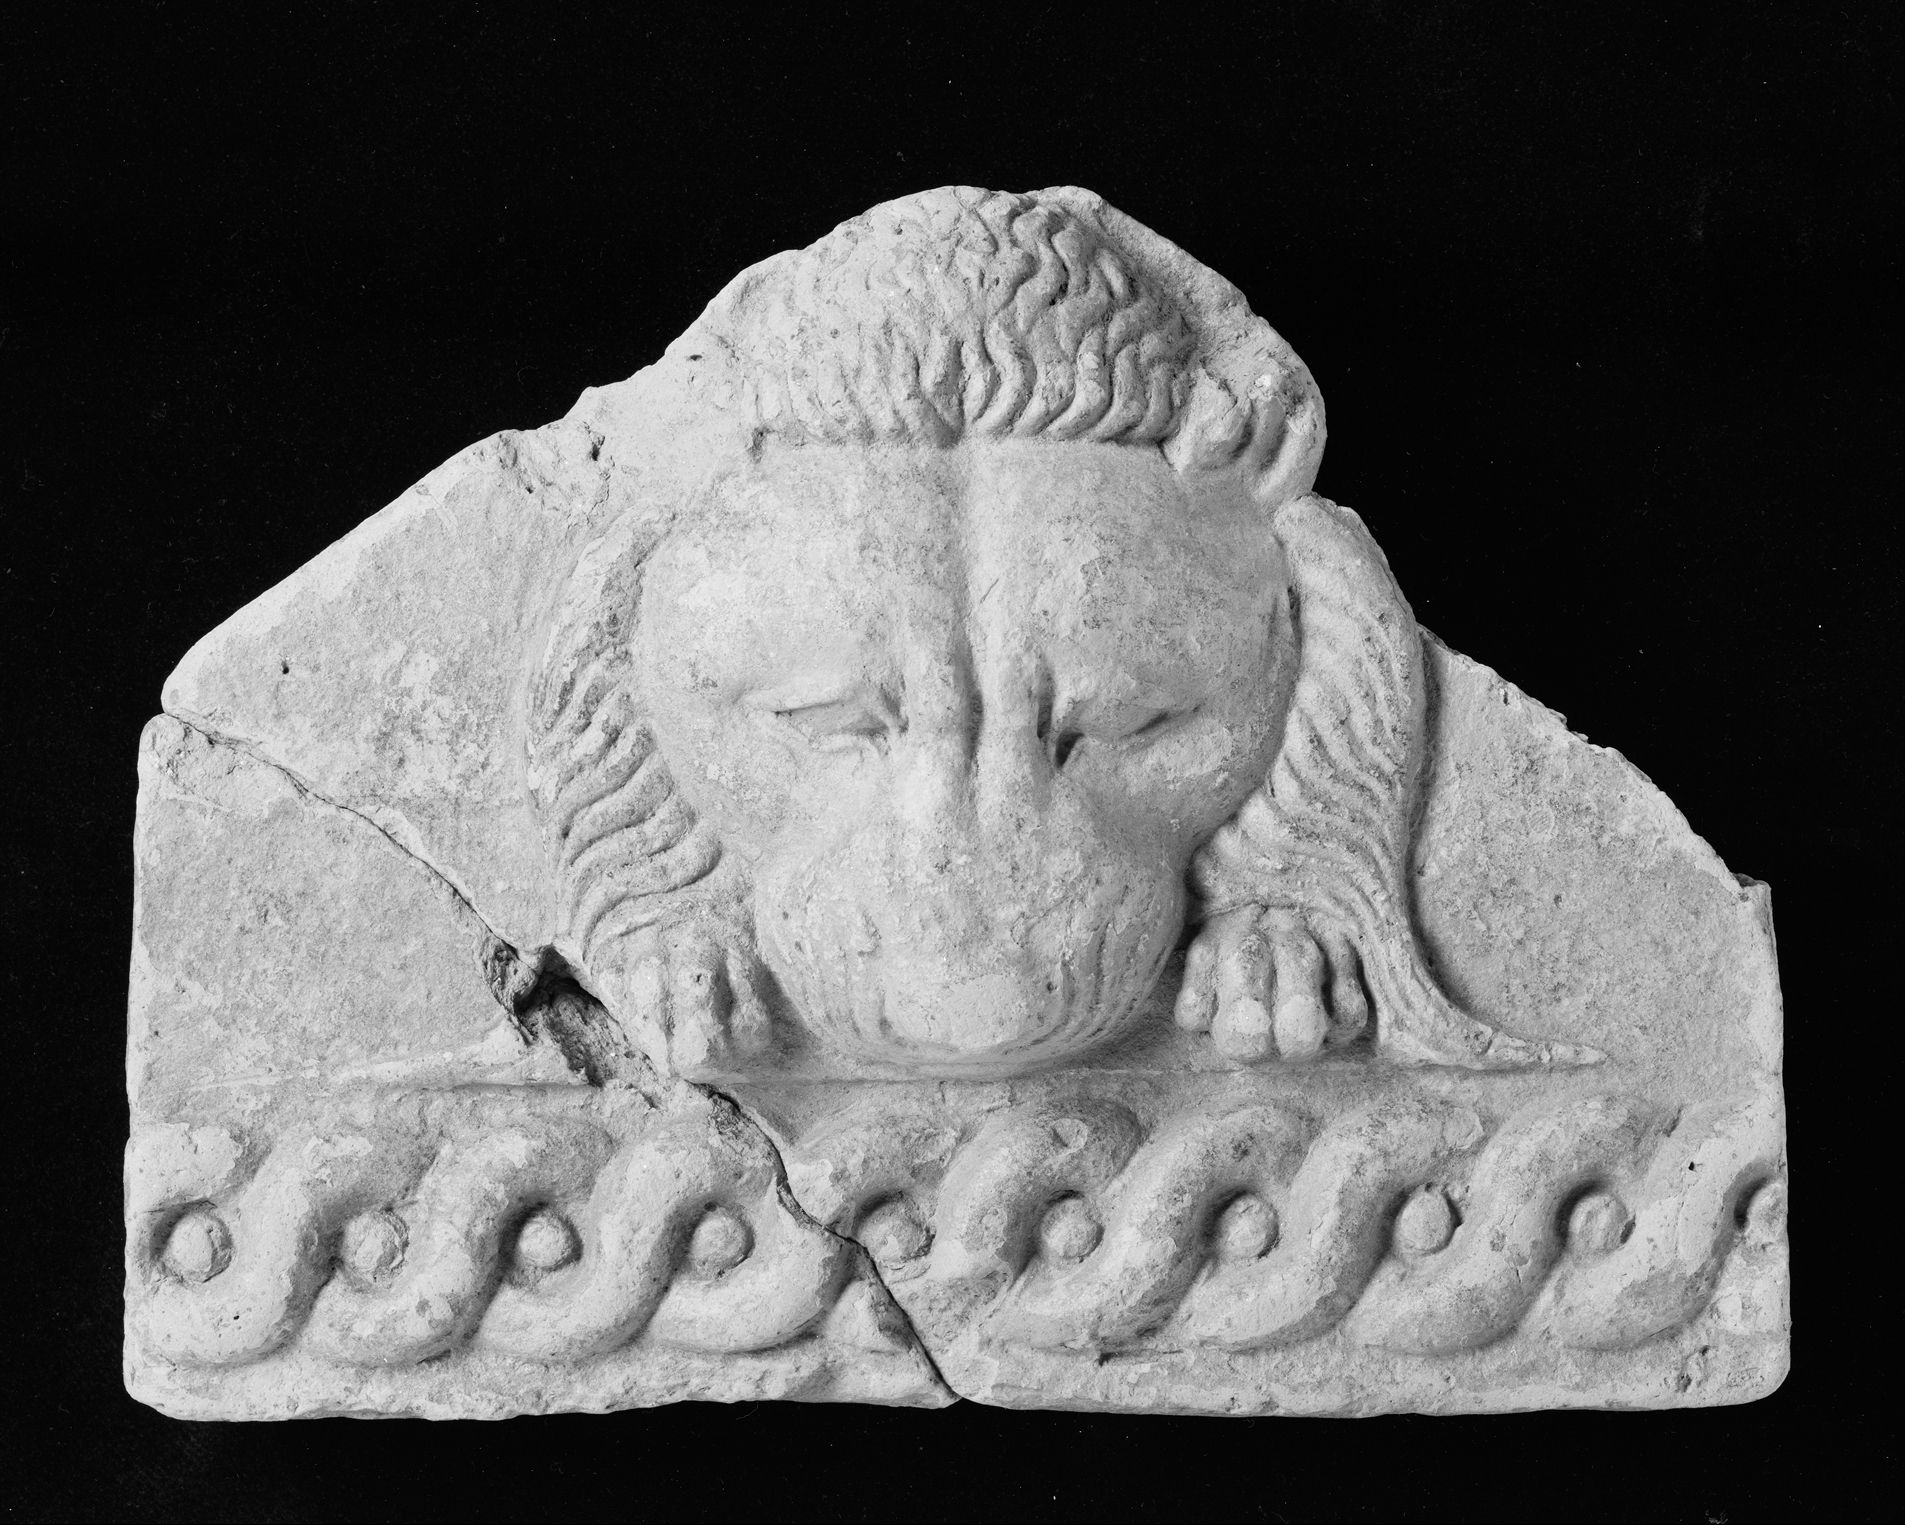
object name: antefix, lion mask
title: Terracotta antefix with lion's head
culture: east greek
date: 534-501 BCE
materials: terracotta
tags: lions